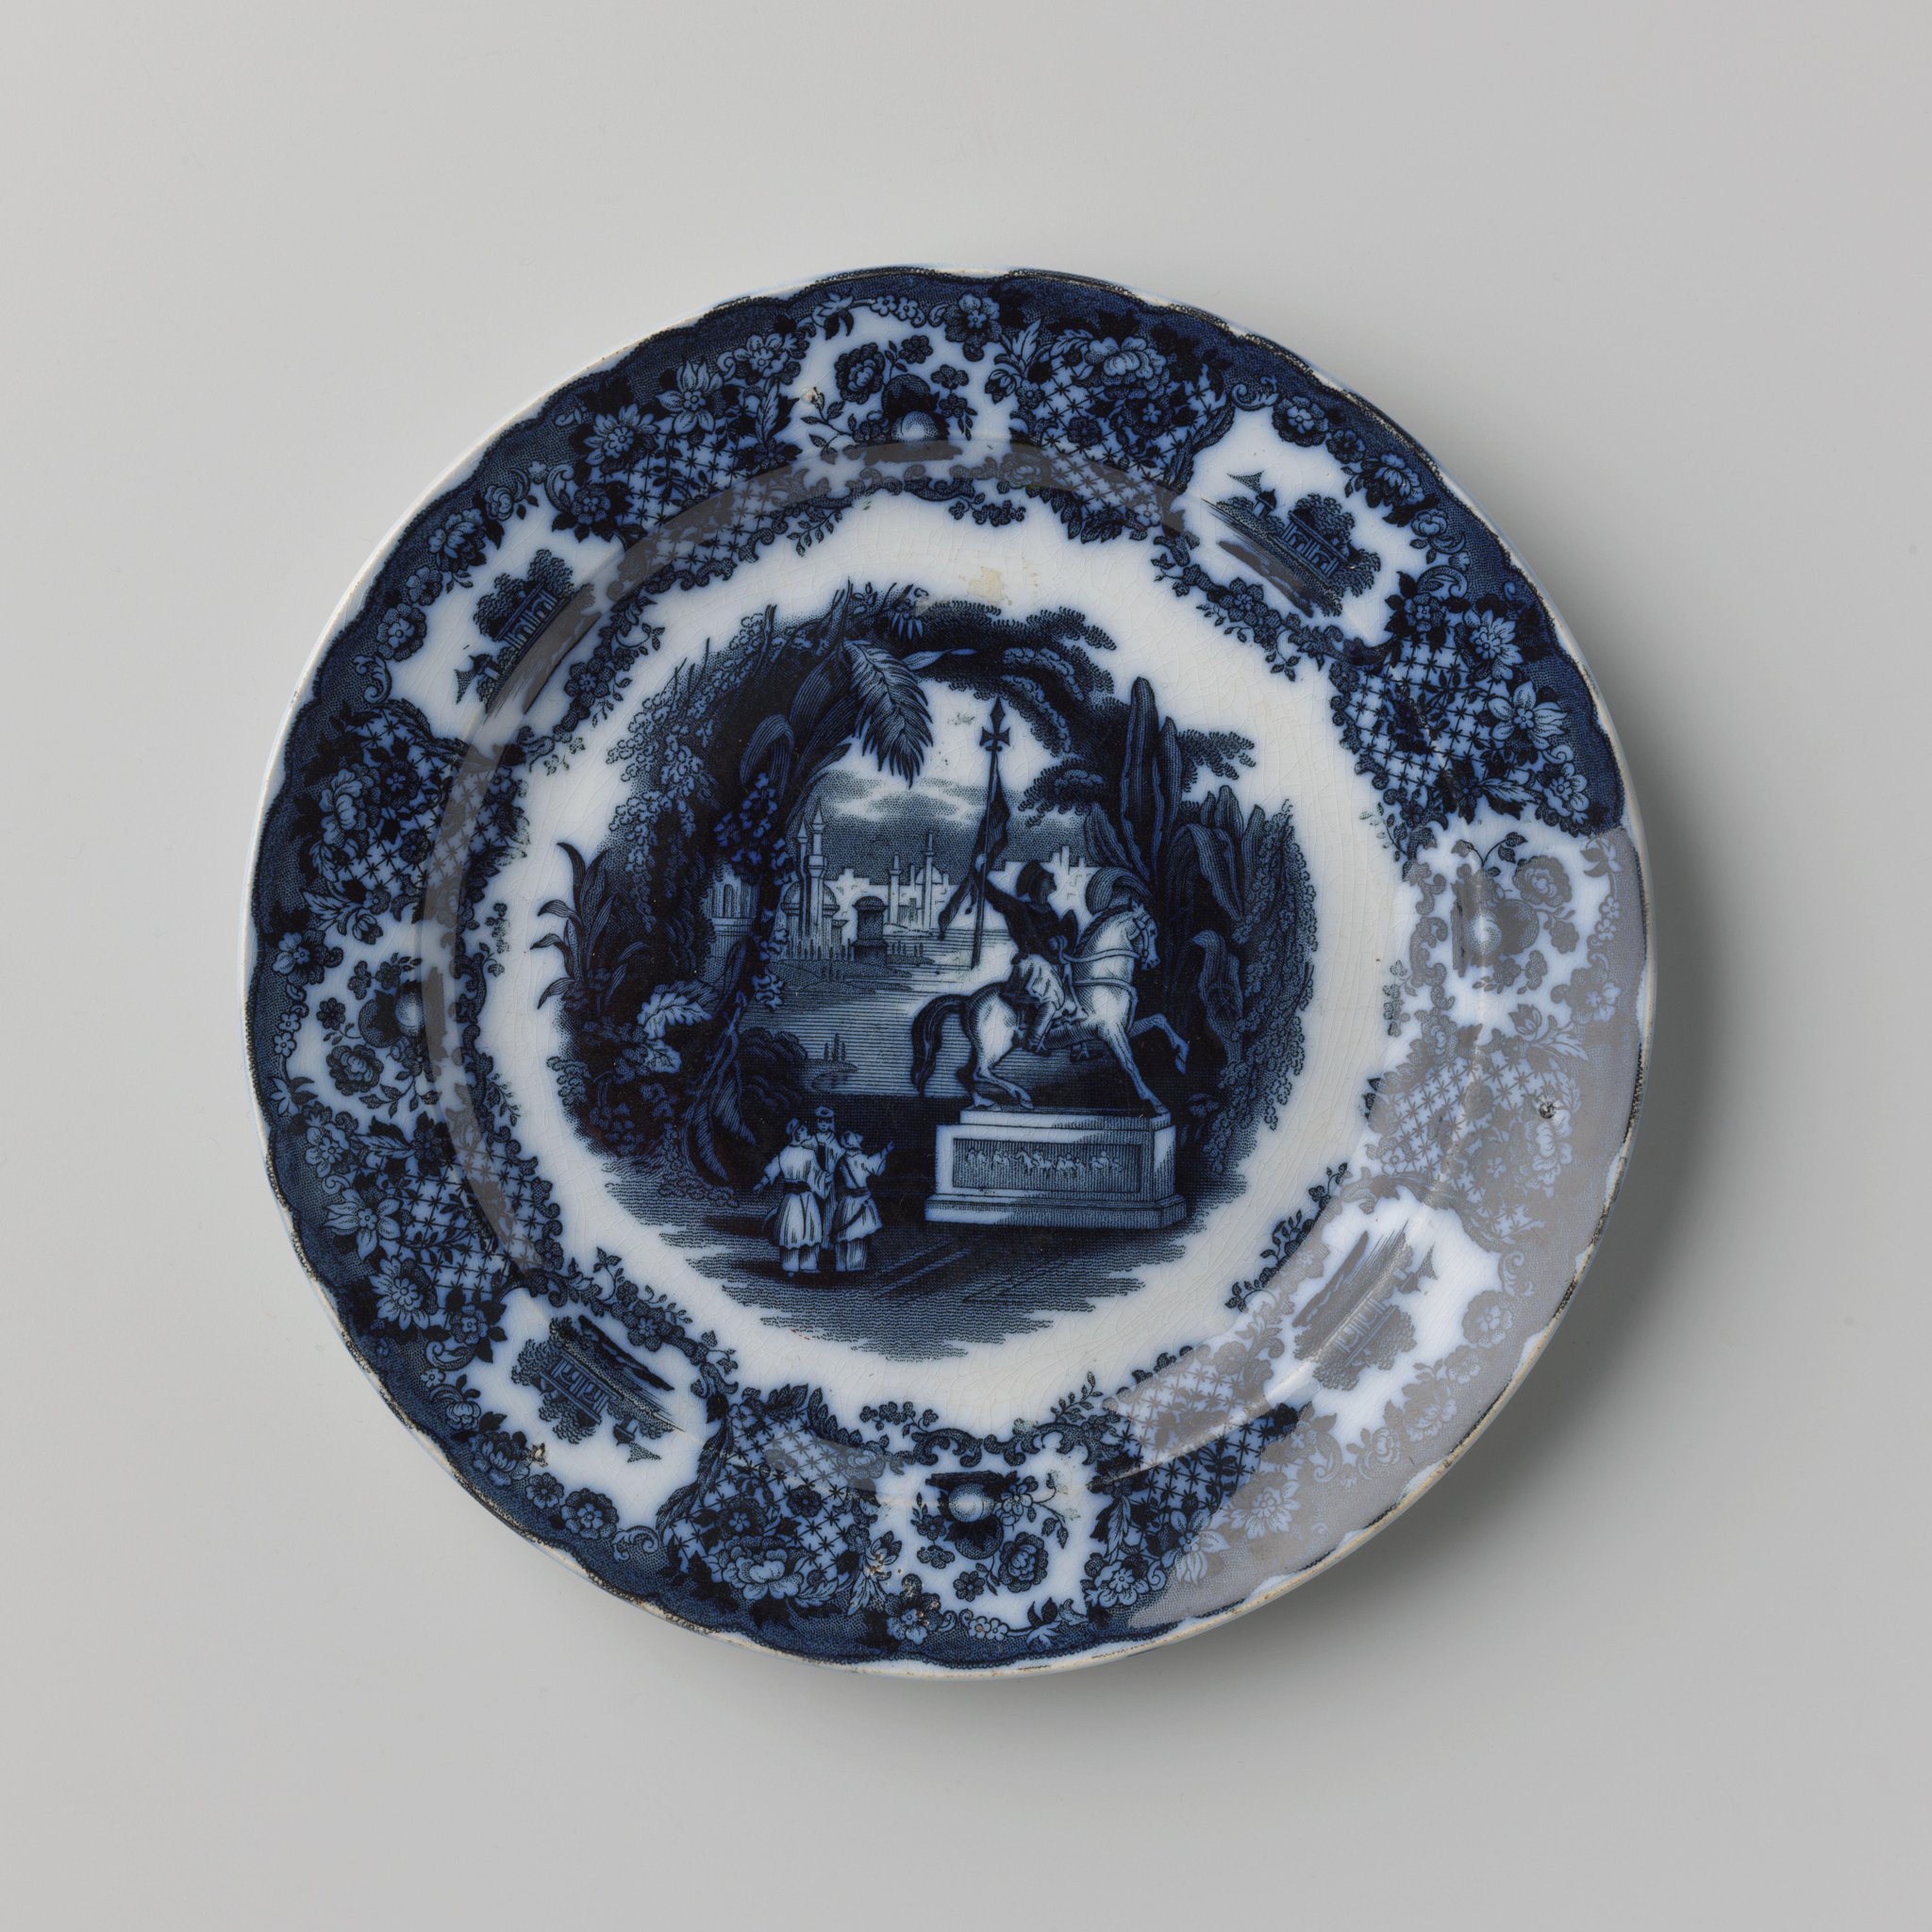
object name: plate dish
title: Bord, met op het plat een oosters landschap met ruiterstandbeeld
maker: petrus regout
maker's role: plateelbakker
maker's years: 1801-1879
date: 1860-1890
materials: creamware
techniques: transfer decoration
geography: maastricht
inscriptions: check stamp: ‘P. REGOUT // 17 // MAASTRICHT’, mark: ‘Staffordshire knot // MAASTRICHT // PETRUS REGOUT // WILLEM DE ZWIJGER’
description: Bord van aardewerk met blauw transferdecor. Op het plat een oosters landschap met ruiterstandbeeld. De rand met cartouches, afwisselend gevuld met boeketten en gebouwen. Tussen de cartouches hekwerk.